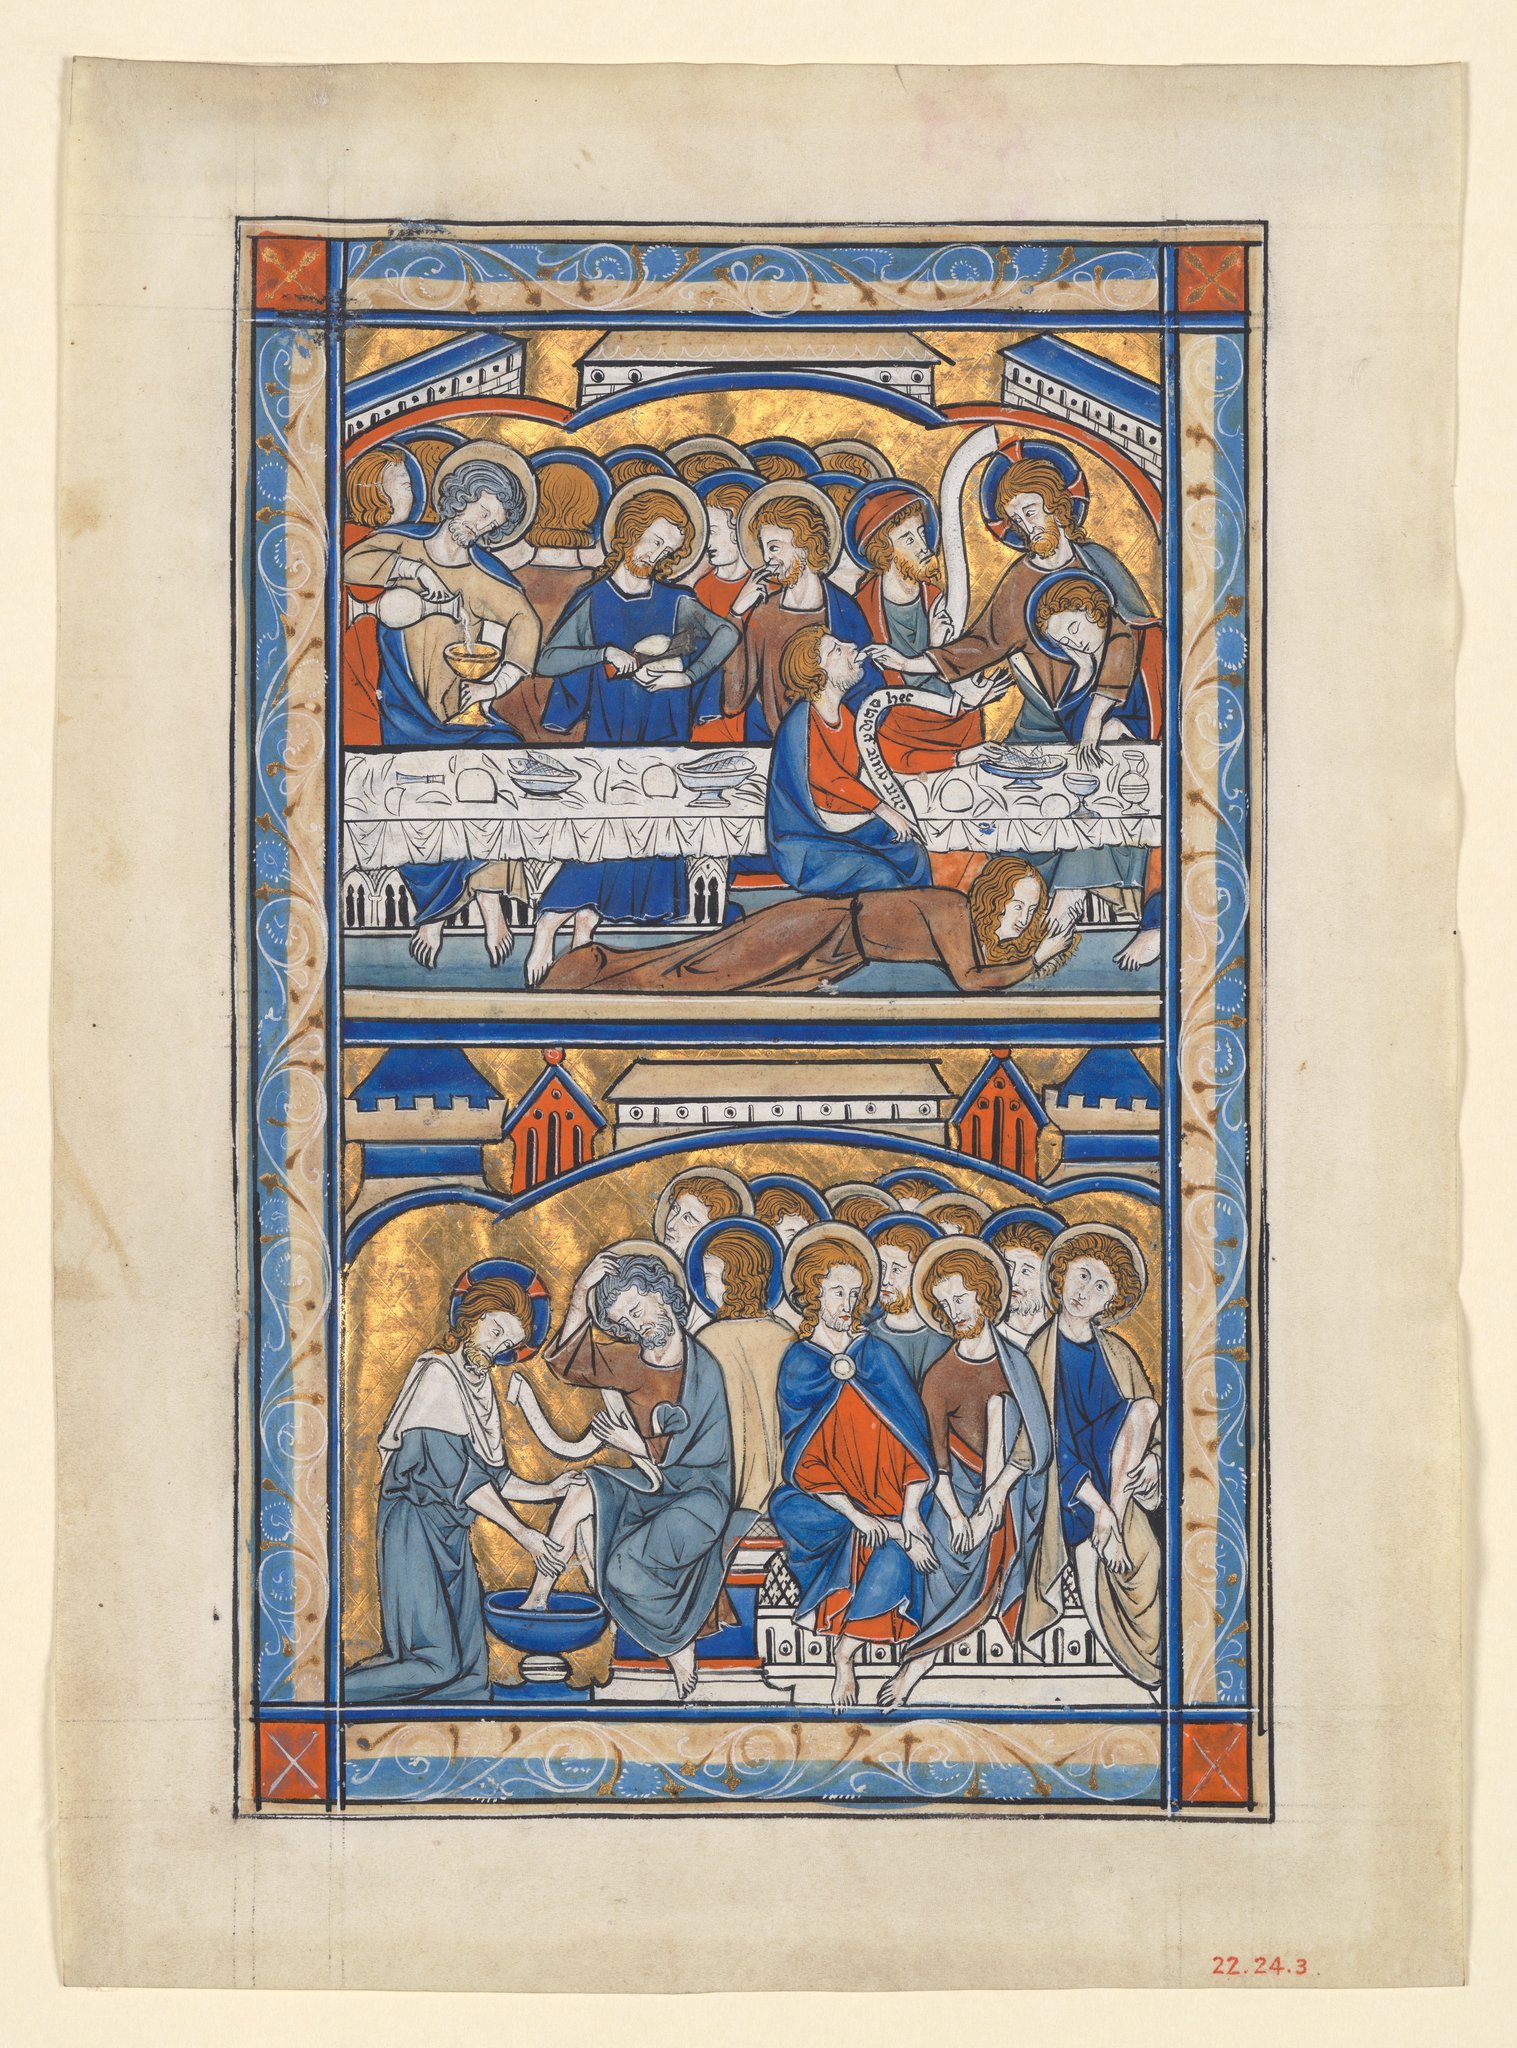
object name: psalter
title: Manuscript Leaf with the Last Supper and the Washing of the Apostles’ Feet Leaf, from a Royal Psalter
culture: british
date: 1250-1270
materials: gold, parchment, paint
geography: england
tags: apostles,christ,last supper